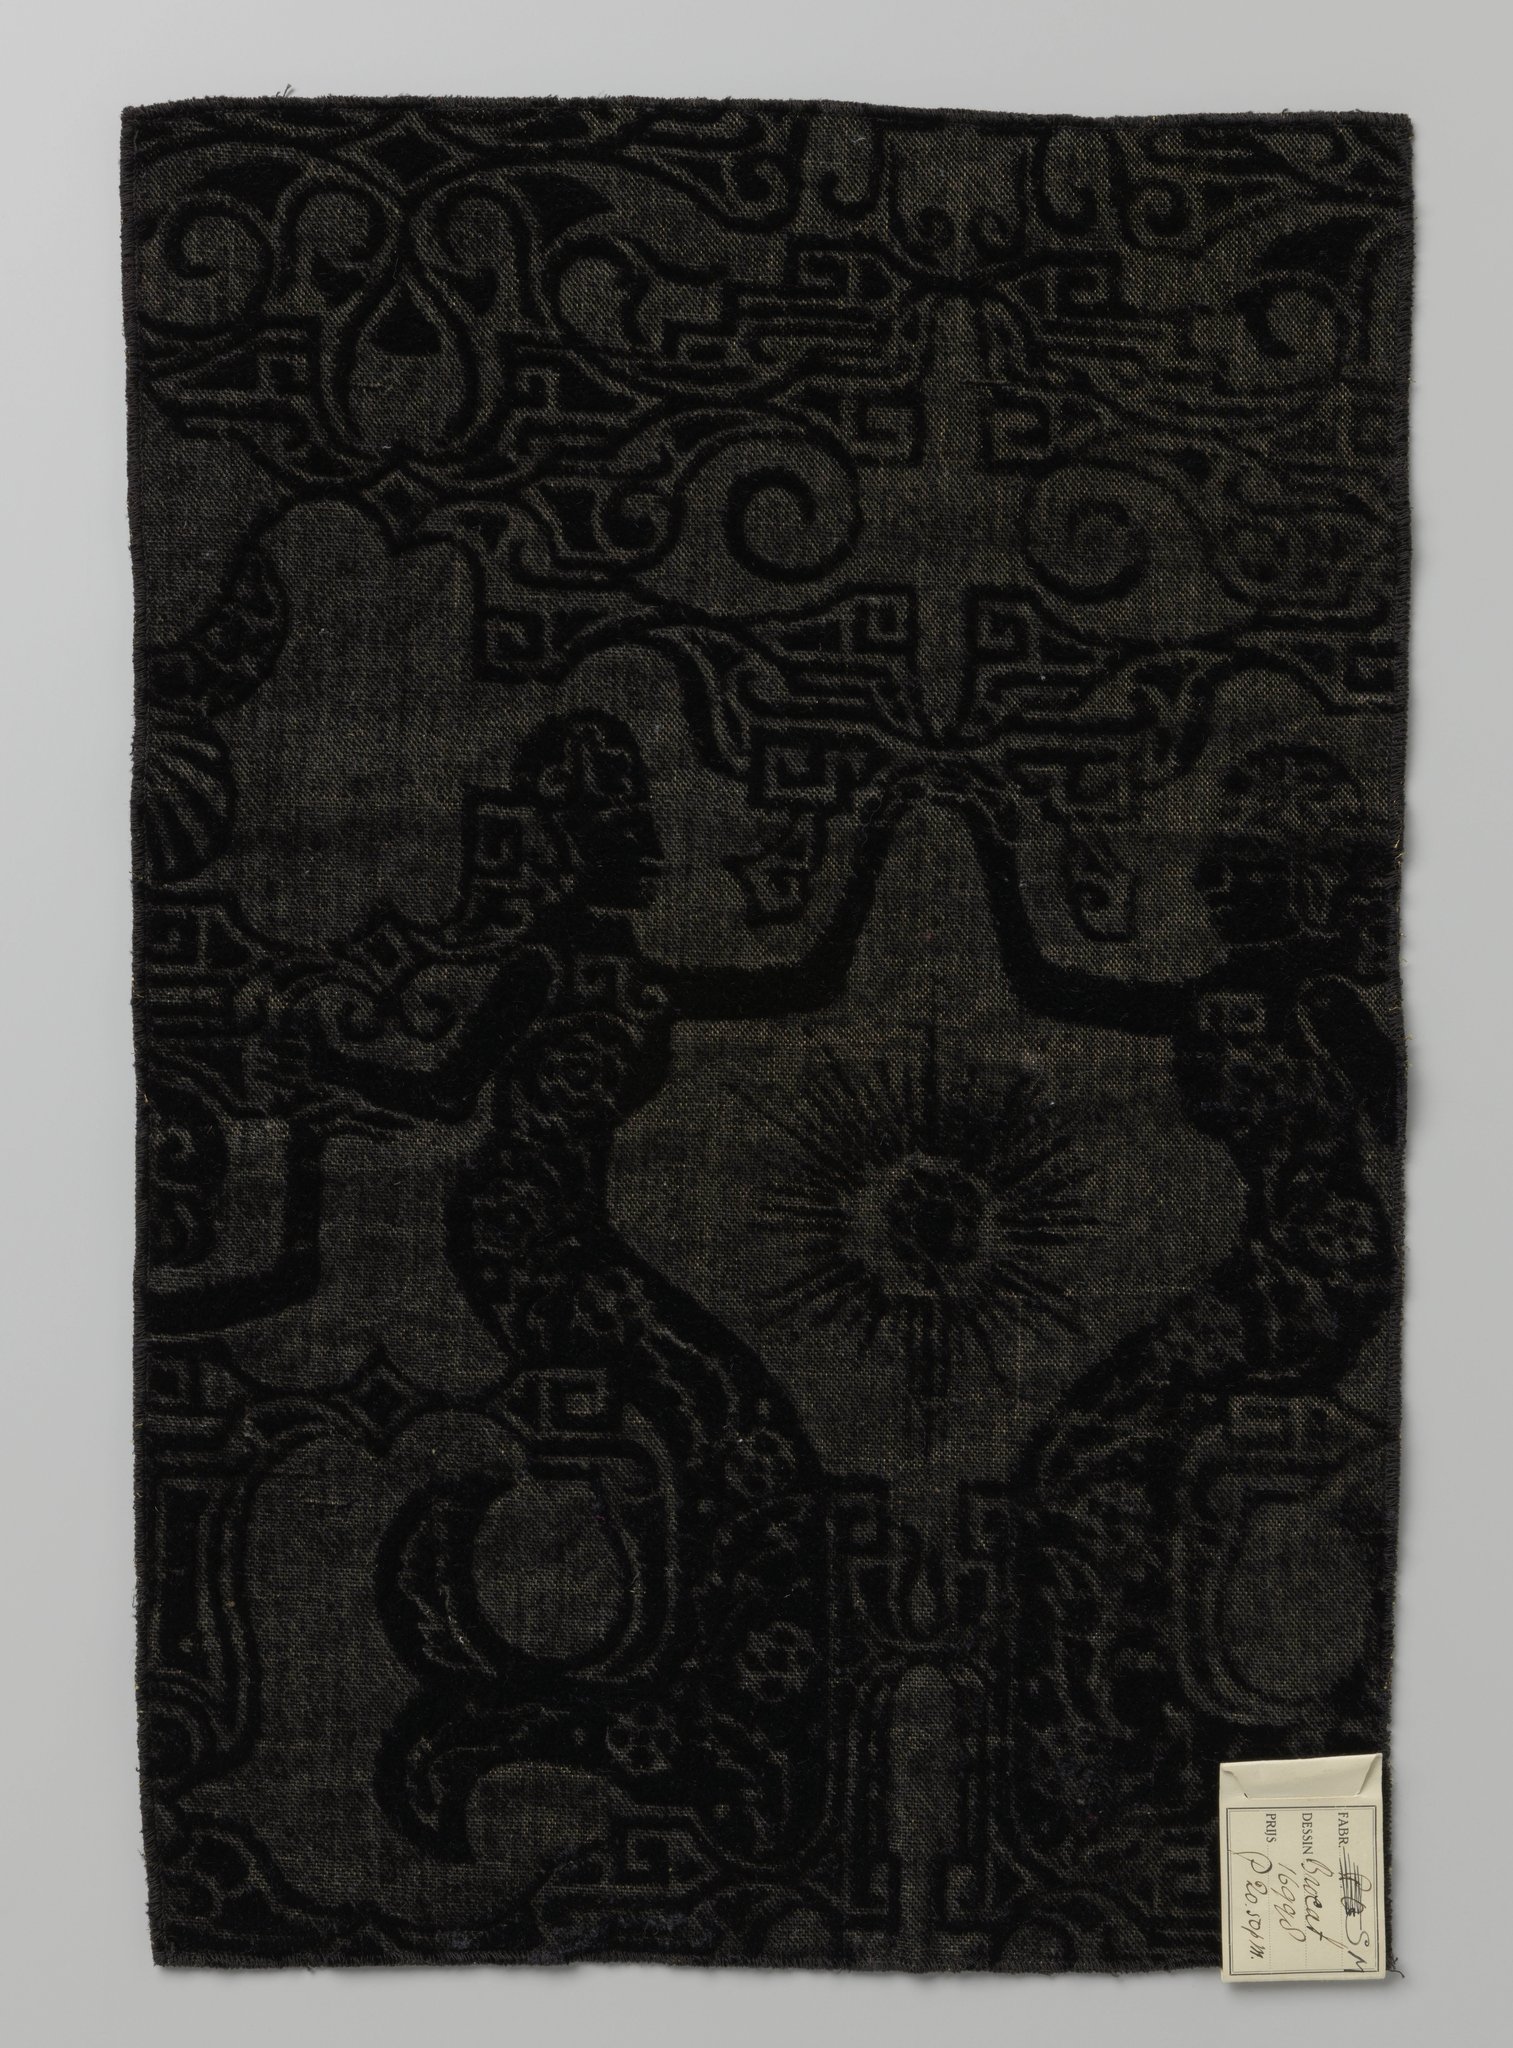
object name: bekledingsstof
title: Fragment ingeschoren fluweel met dessin "Zeenymphen", donkerblauw op goud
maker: carel adolph lion cachet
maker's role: draughtsman, print maker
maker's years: 1864-1945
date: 1918-1925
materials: cotton, textile, hair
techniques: relief velvet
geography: eindhoven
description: Fragment ingeschoren fluweelmet dessin "Zeenymphen", donkerblauw op goud.